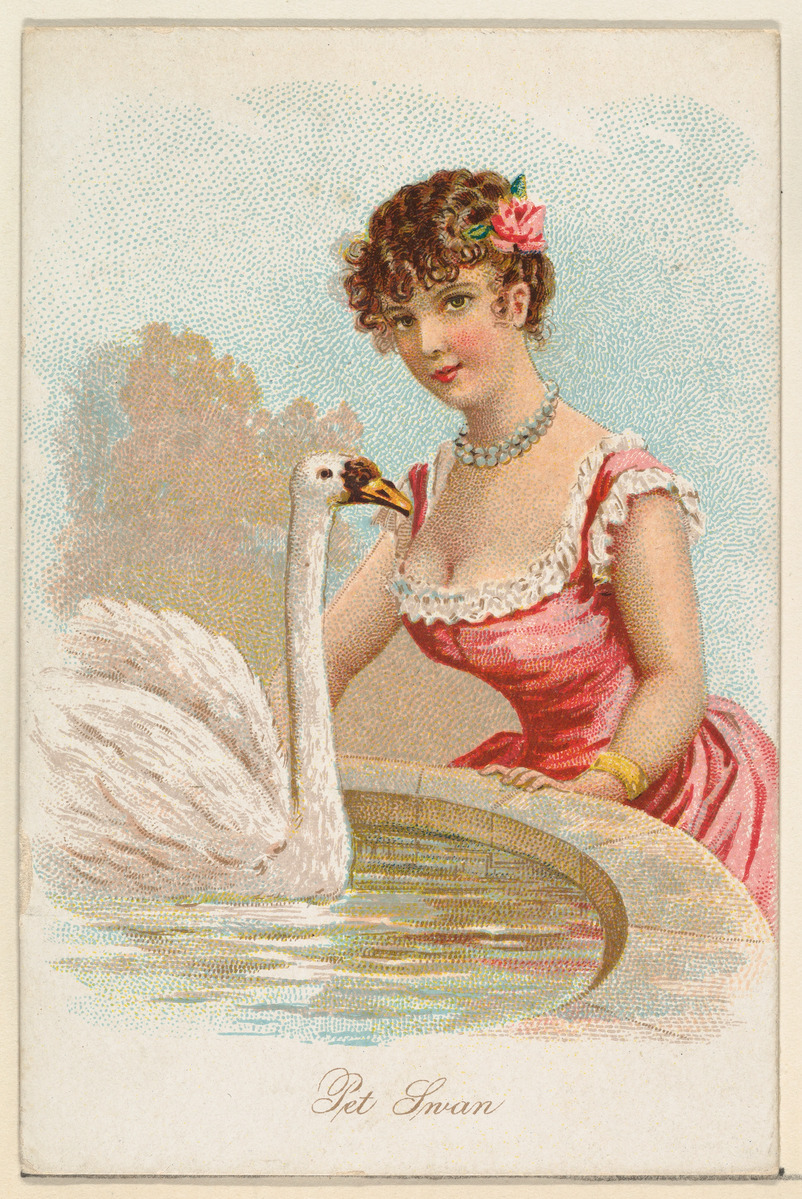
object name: print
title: Pet Swan, from the Household Pets series (N194) issued by Wm. S. Kimball & Co.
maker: william s. kimball & company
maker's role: publisher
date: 1891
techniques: color lithograph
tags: women,swans